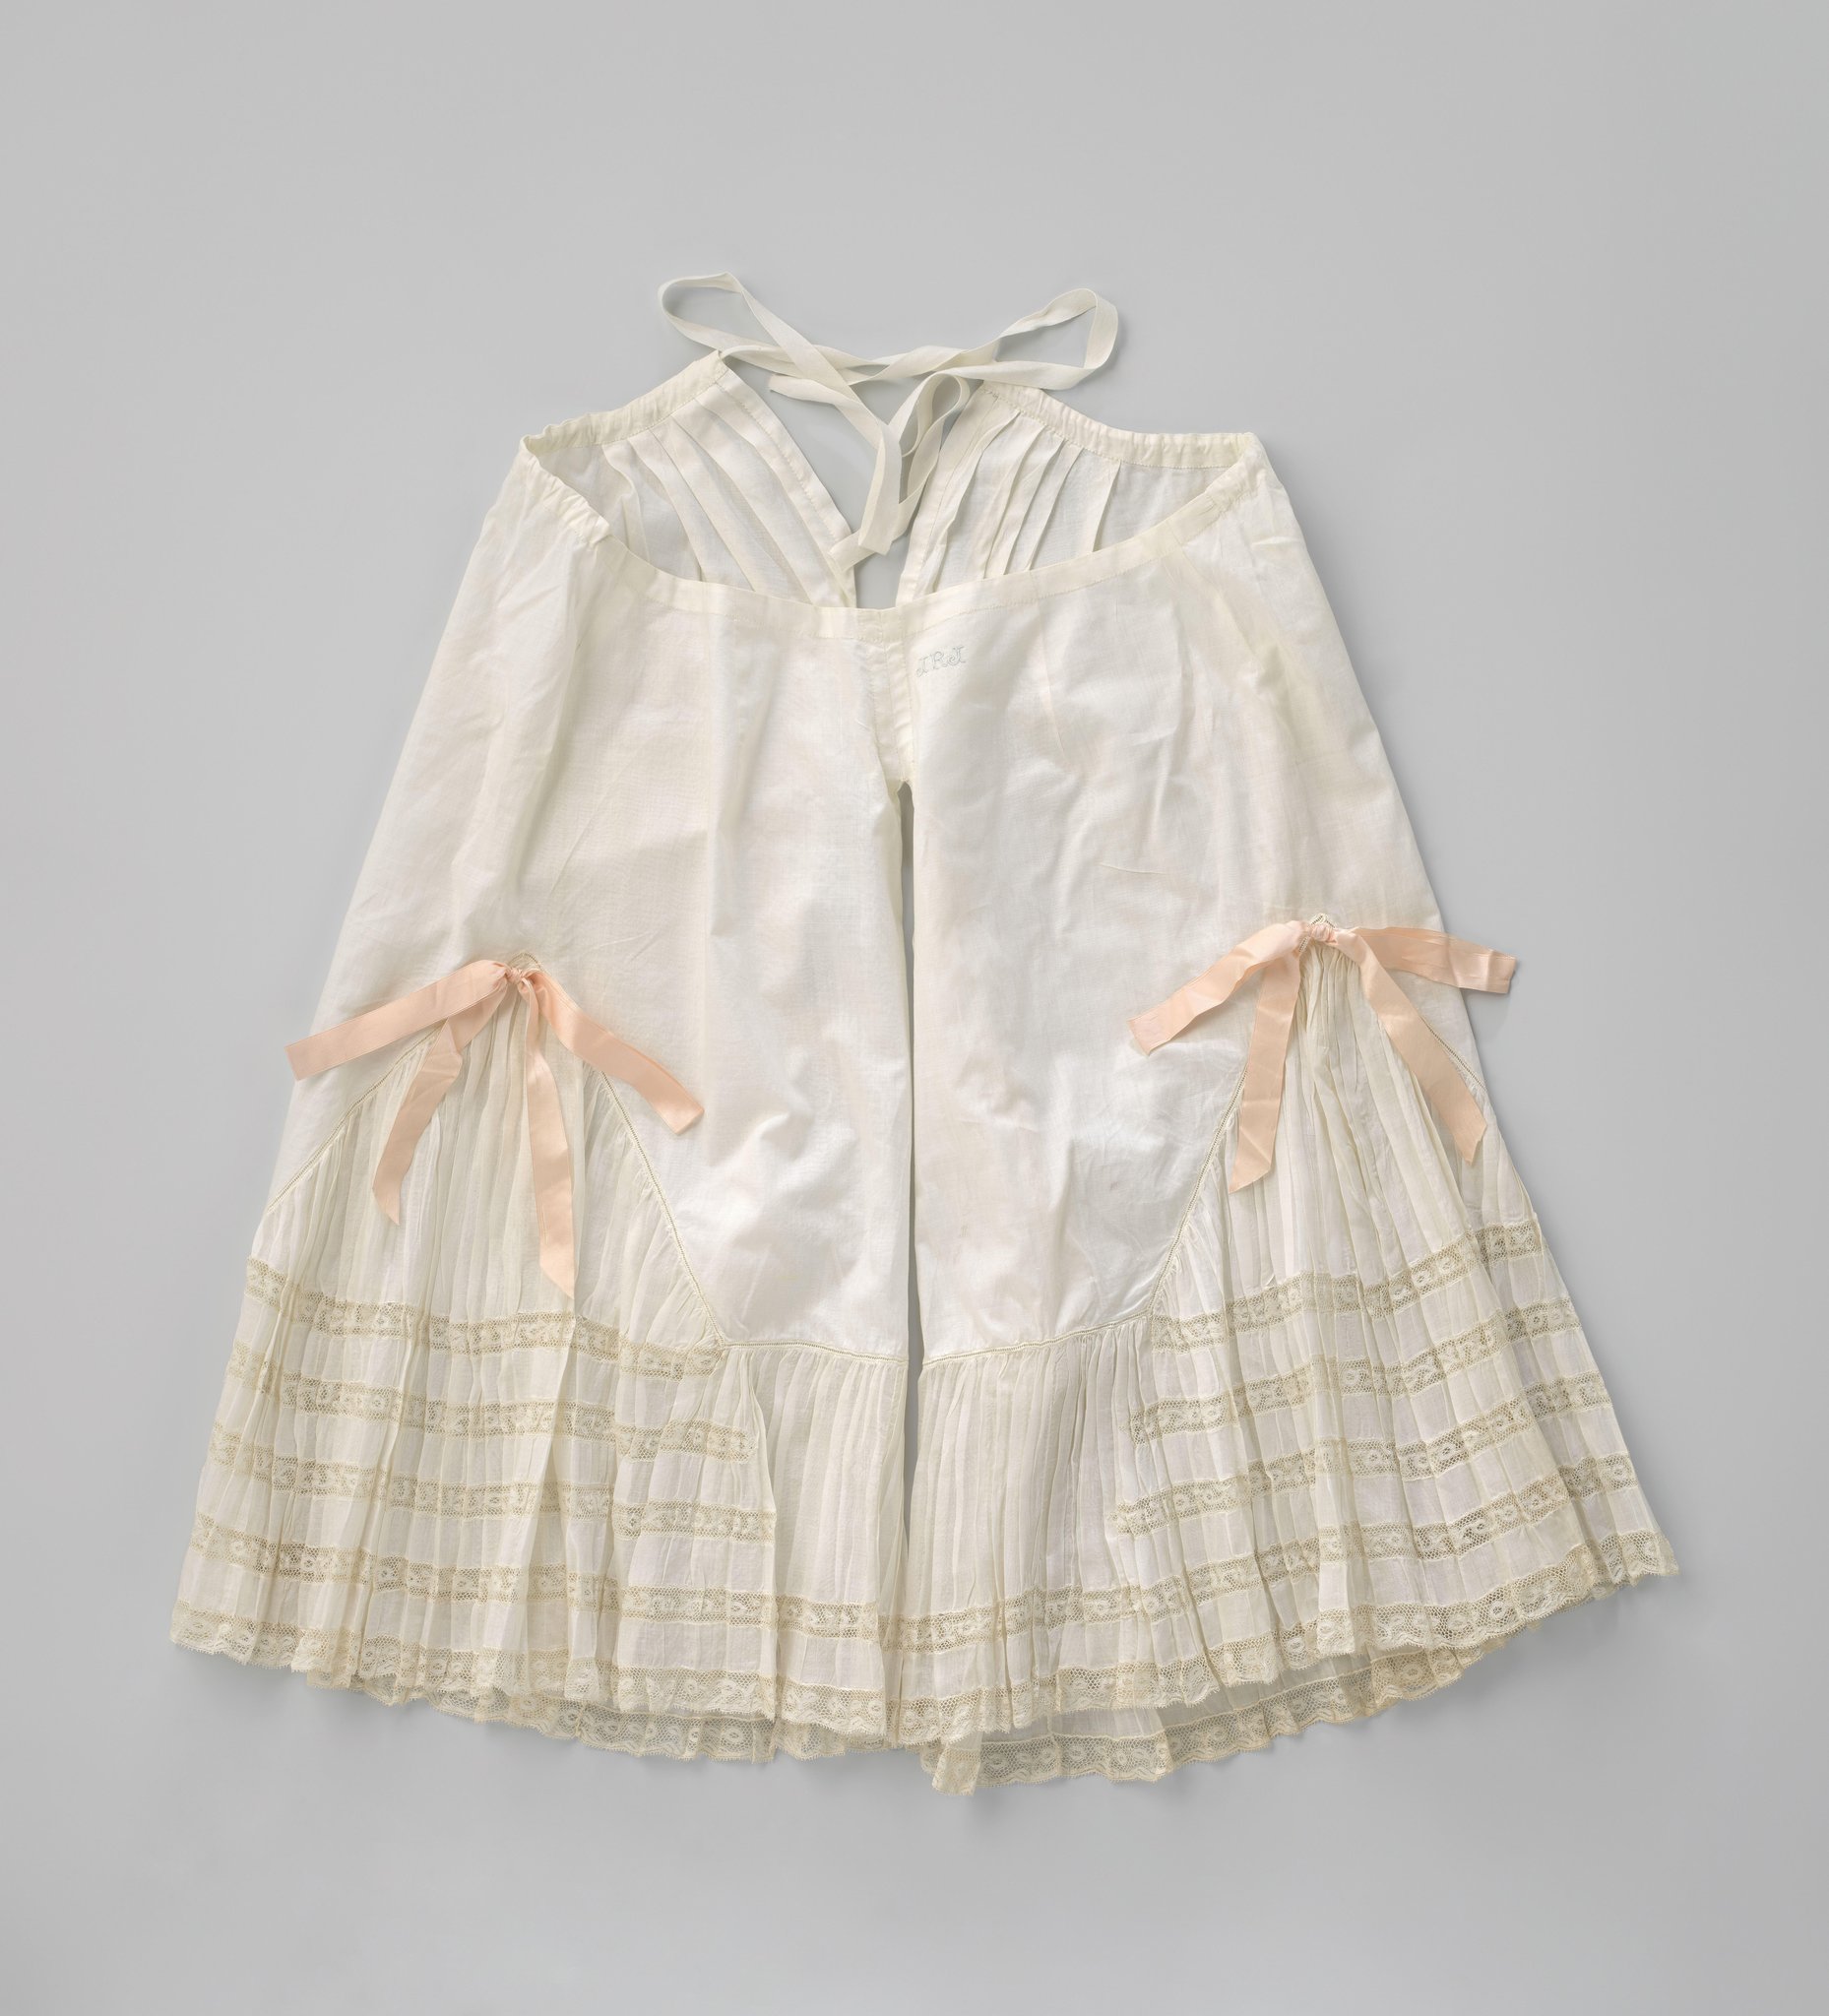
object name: womenswear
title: Drawers without crotch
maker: Anonymous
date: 1905-1915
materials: textile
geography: amsterdam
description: From the moment the hoop skirt (crinoline) went out of fashion in Paris in the 1860s, Dutch women had their metal hoops bent backwards into an oval by the blacksmith. A long, slender silhouette with emphasis on the buttocks was now expected and so the bustle (tournure) began its rise, sometimes incorporated into a skirt but also as a loose piece fastened around the waist.